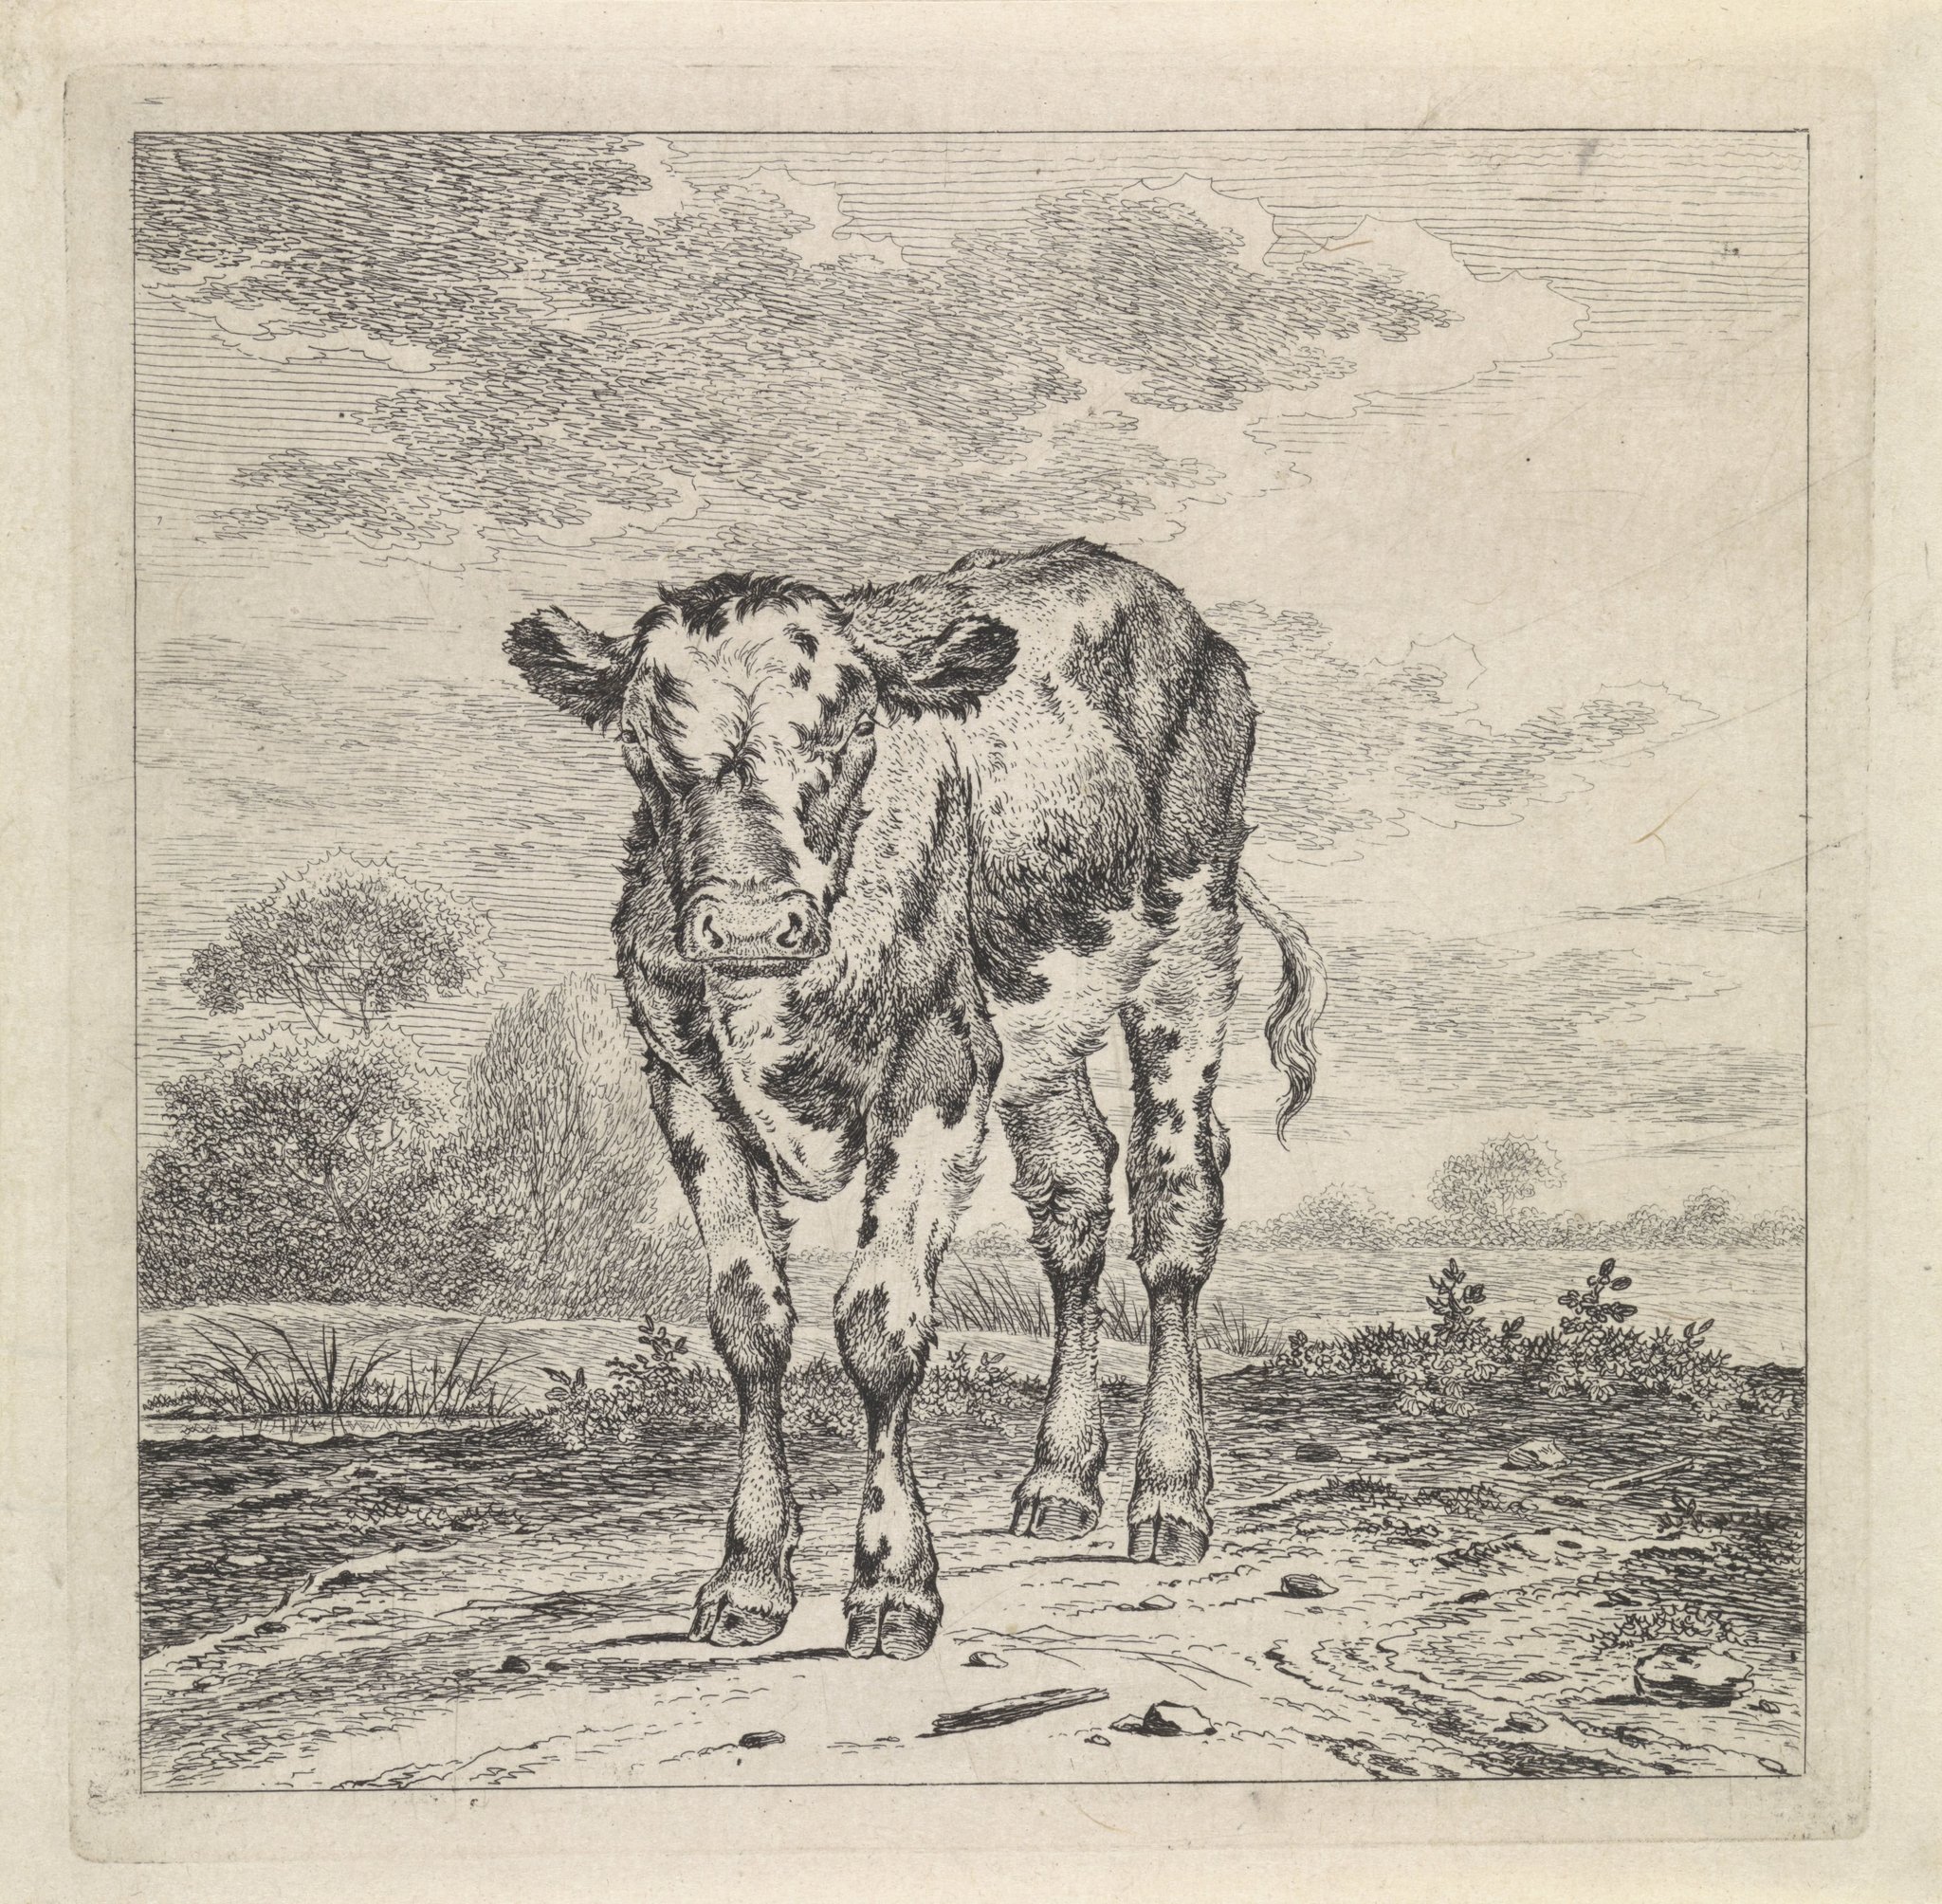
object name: print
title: Landschap met kalf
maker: pieter janson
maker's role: draughtsman, print maker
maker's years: 1765-1851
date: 1780-1851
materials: paper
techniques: etching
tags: calf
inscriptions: collector's mark: Lugt 2228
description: Landschap met kalf, van voren gezien. Meer bewerkt dan vorige staten.